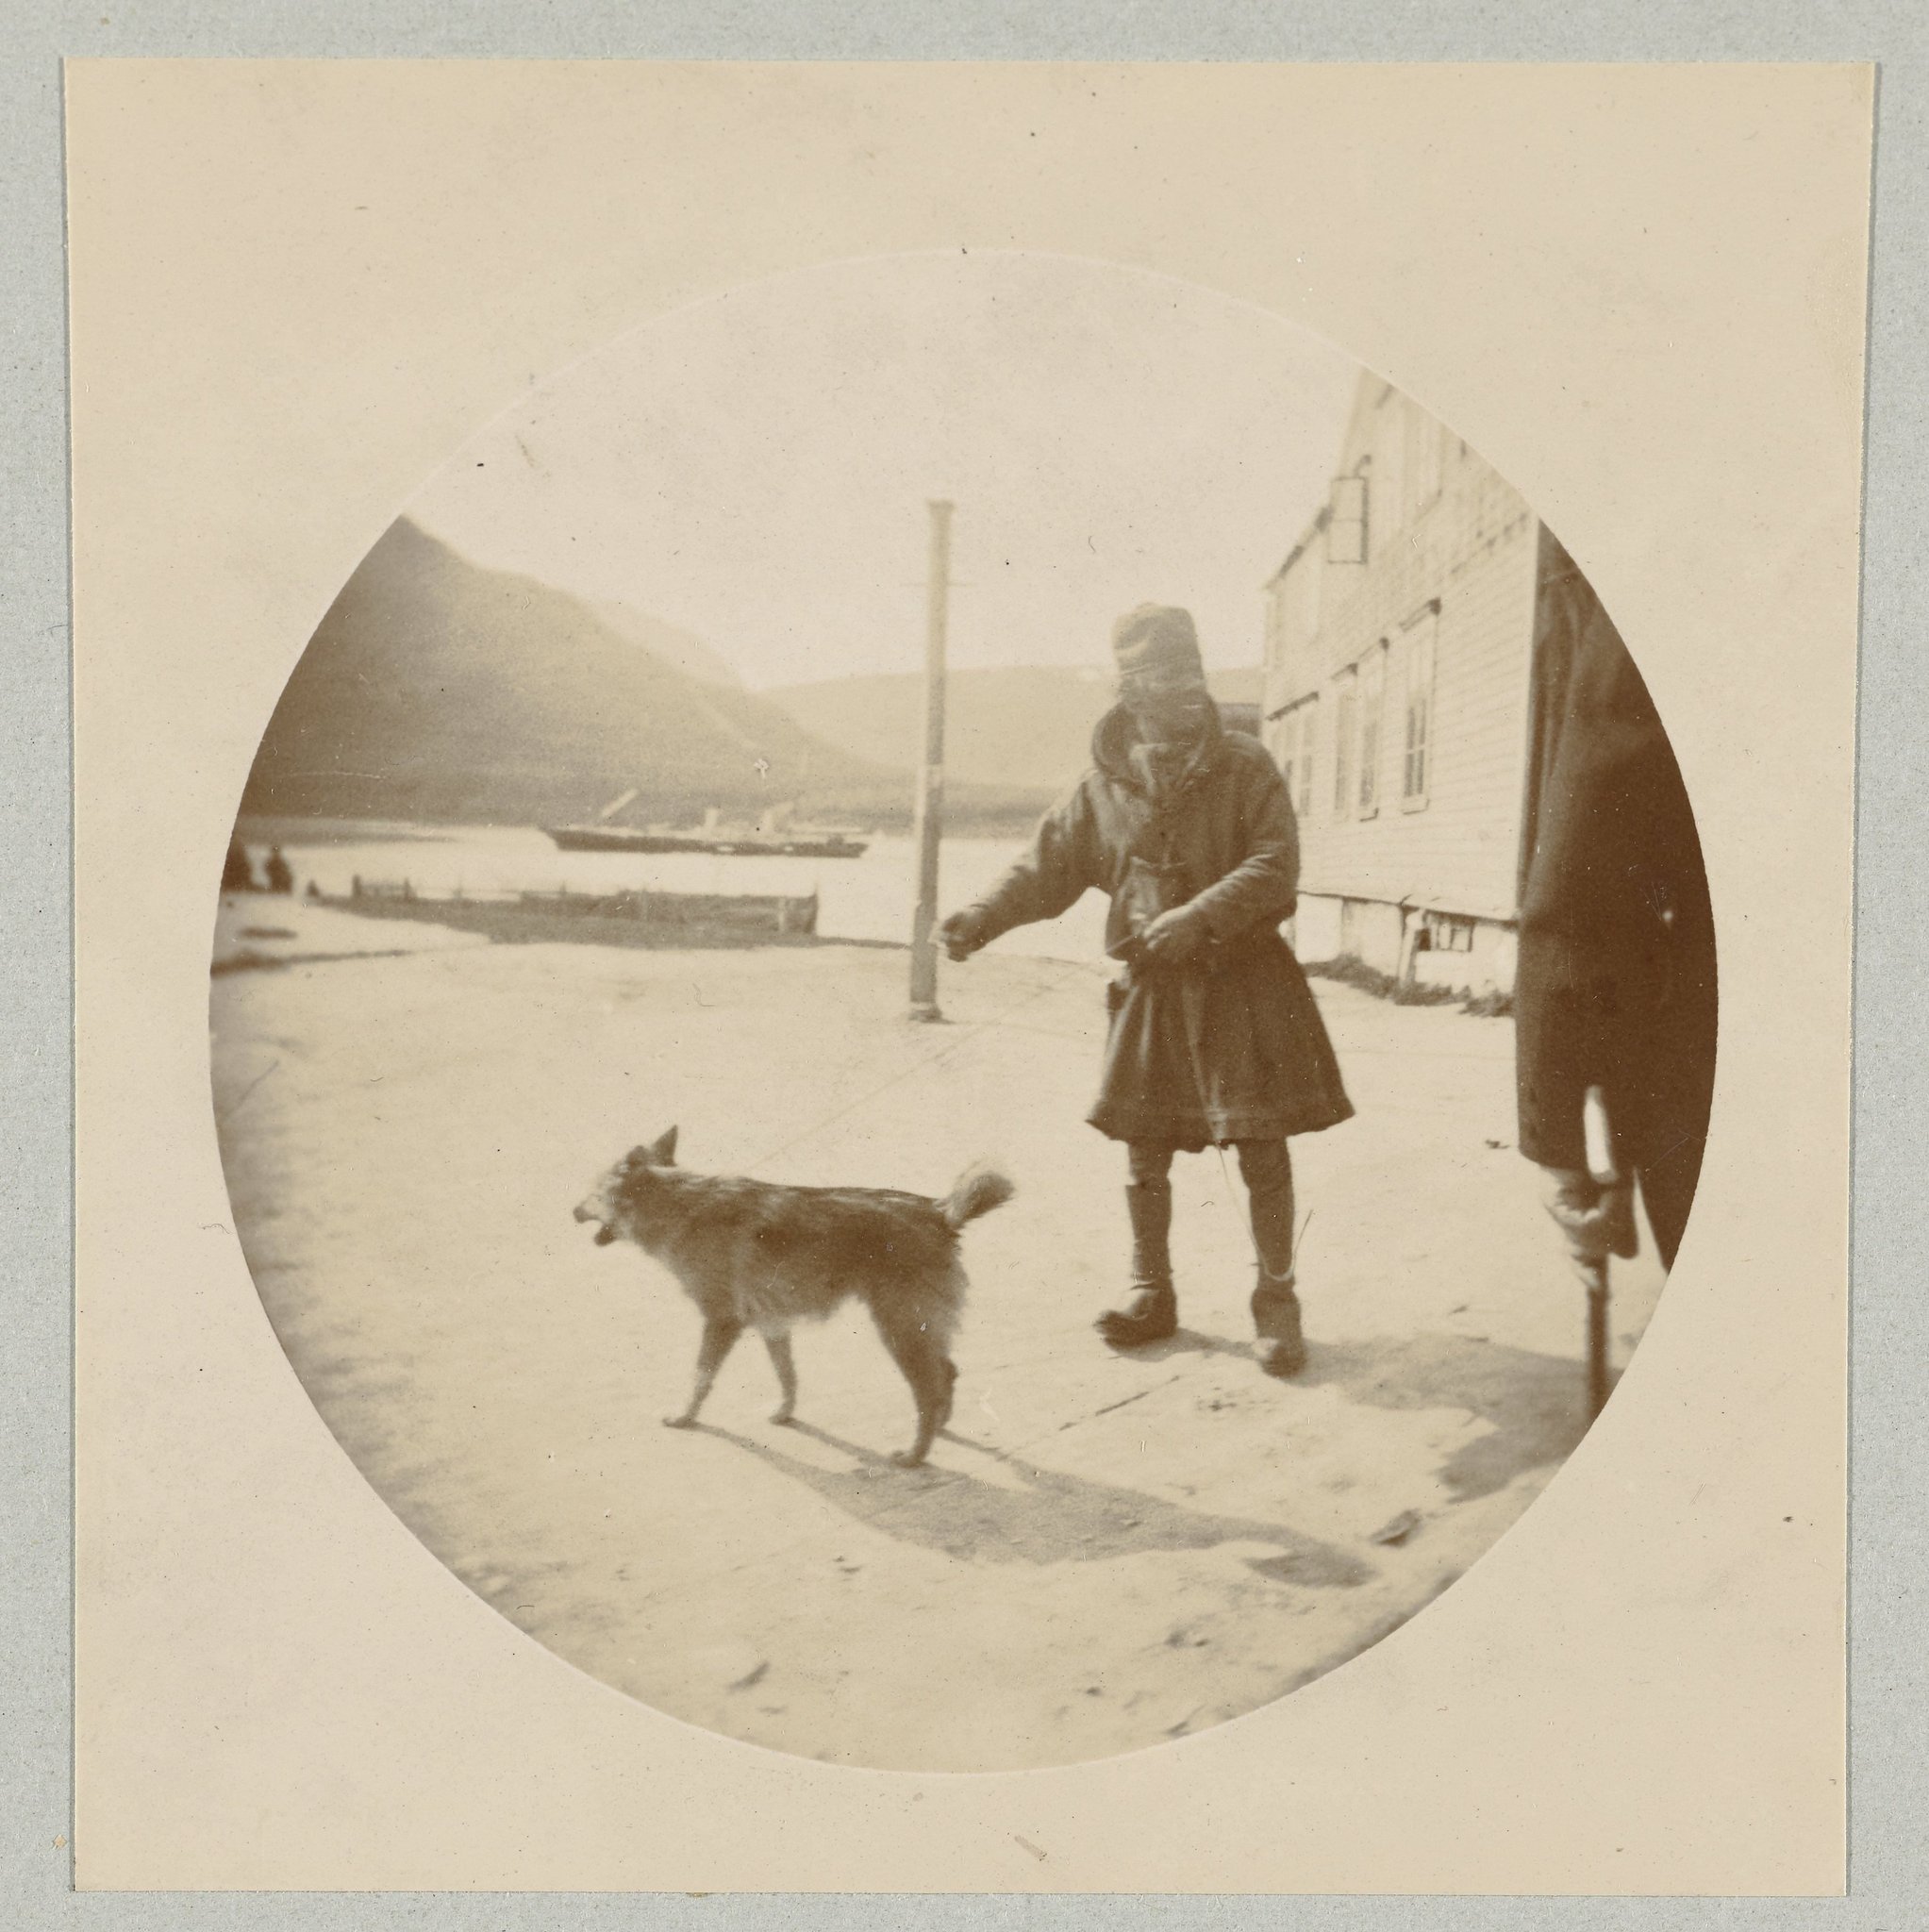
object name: photograph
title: Man in Saami kleding met een hond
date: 1807-1889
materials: cardboard, paper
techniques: gelatin silver print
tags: norway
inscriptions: number: ‘31’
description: De afdruk van de foto is rond, het papier vierkant. foto gemaakt met Nr. 1 Kodak Camera